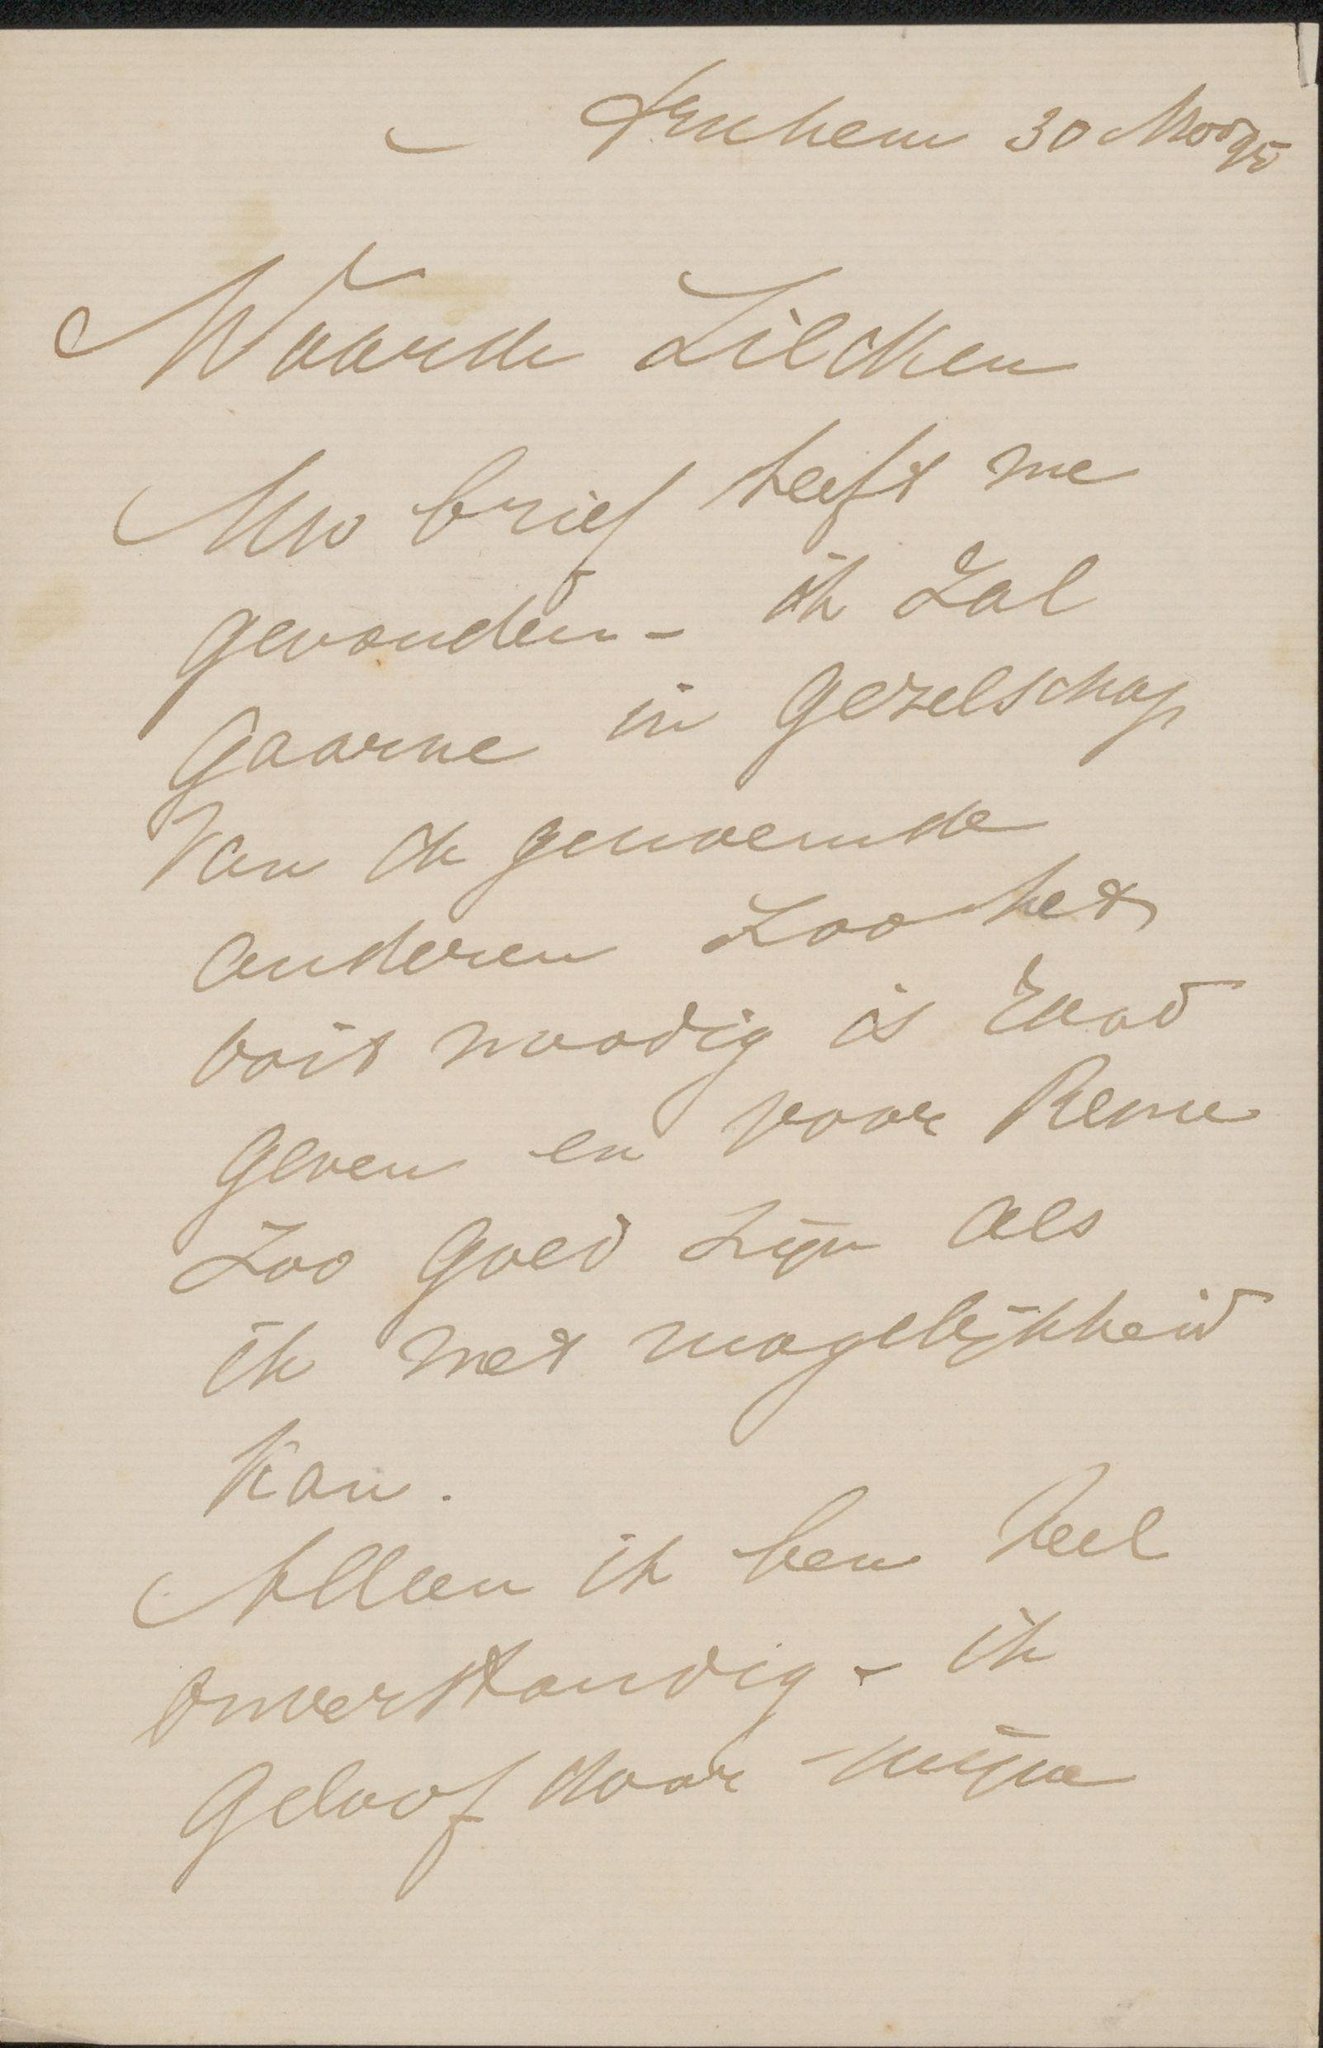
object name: letter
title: Brief aan Philip Zilcken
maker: saar de swart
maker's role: sculptor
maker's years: 1861-1951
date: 1895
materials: ink, paper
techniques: pen, writing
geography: arnhem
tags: deventer, martha van vloten, the hague, painter, philip zilcken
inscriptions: collector's mark: ‘RPK’